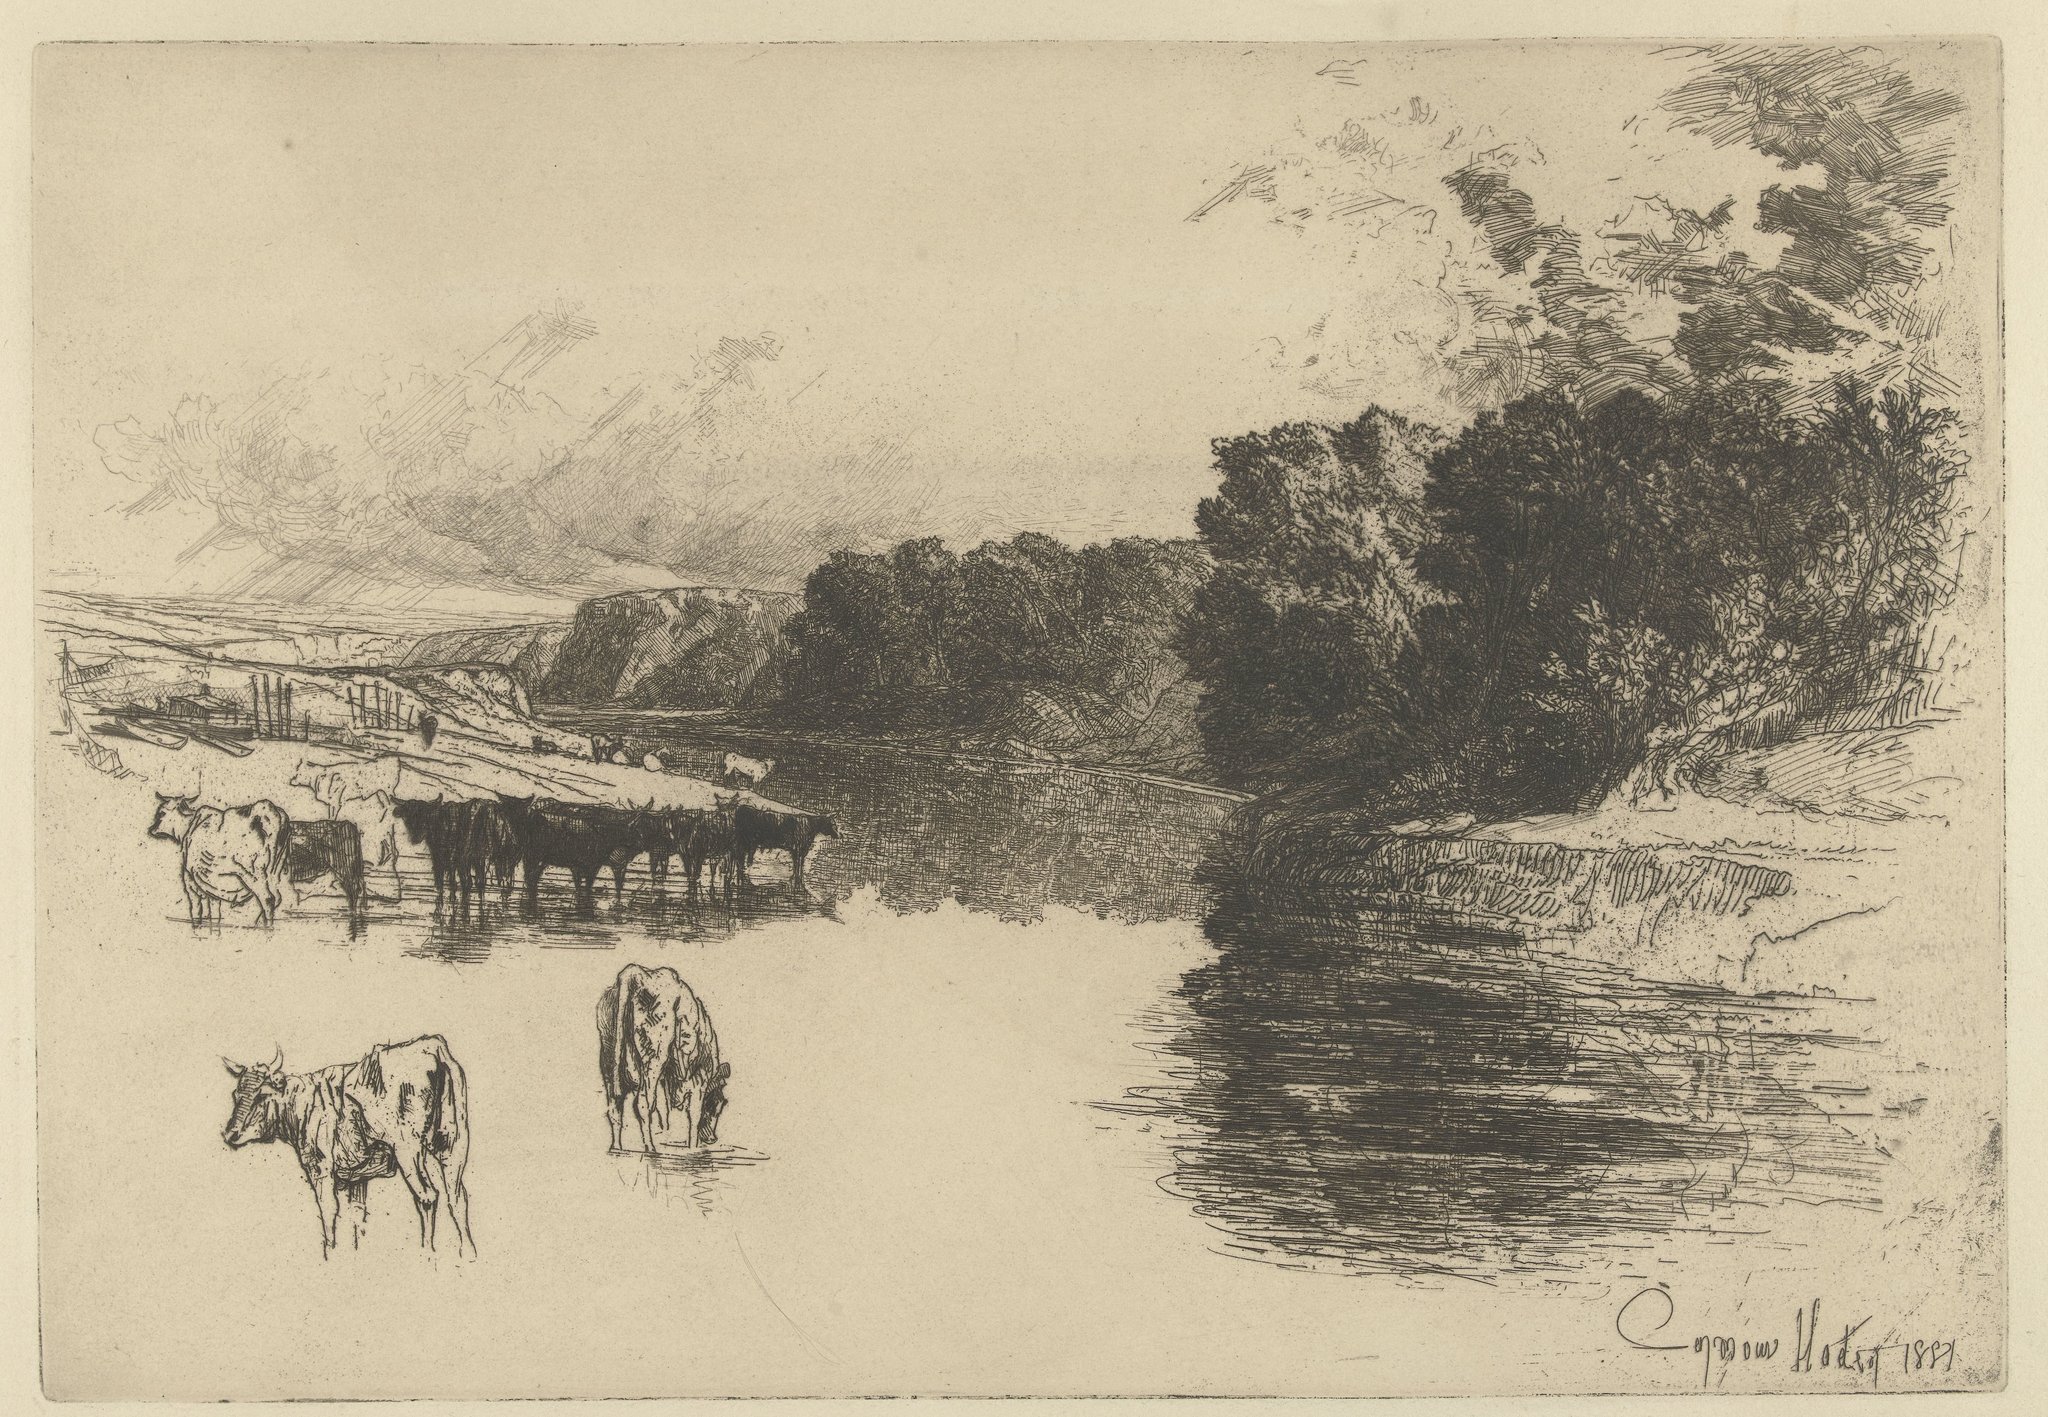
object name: print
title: A Lancashire River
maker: francis seymour-haden (sir)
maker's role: print maker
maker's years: 1818-1910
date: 1881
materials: paper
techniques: drypoint, etching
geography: england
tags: river, animals (+ herd, group of animals)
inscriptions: collector's mark: Lugt 2228, signature: ‘Seymour haden’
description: Een rivier stromend door een landschap. Op de linker oever en staand in het water een kudde koeien.